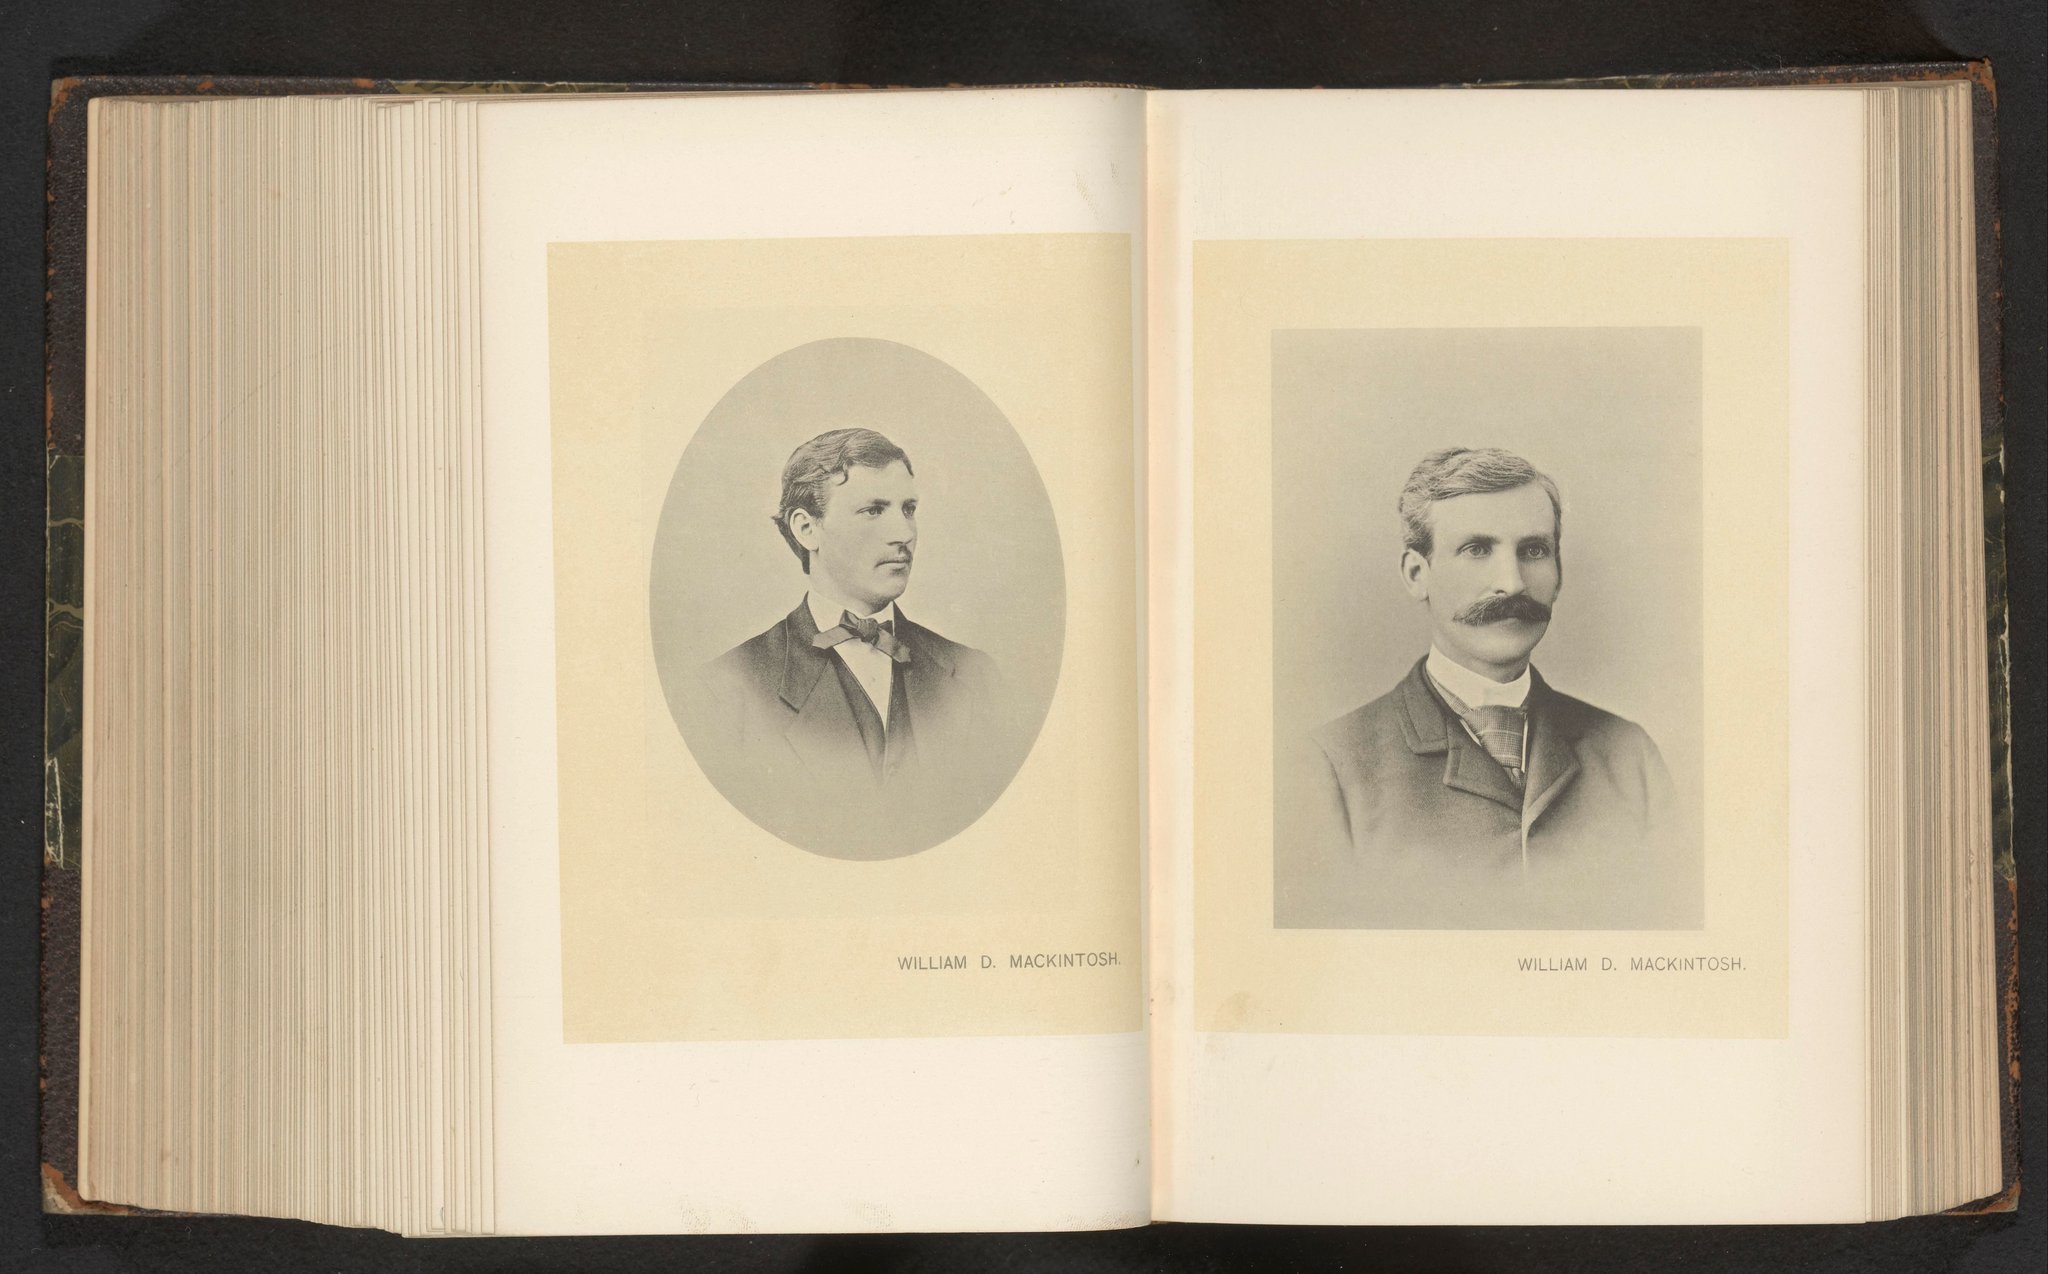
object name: page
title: William D. Mackintosh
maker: Anonymous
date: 1869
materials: paper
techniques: photoaquatint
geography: boston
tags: adult man